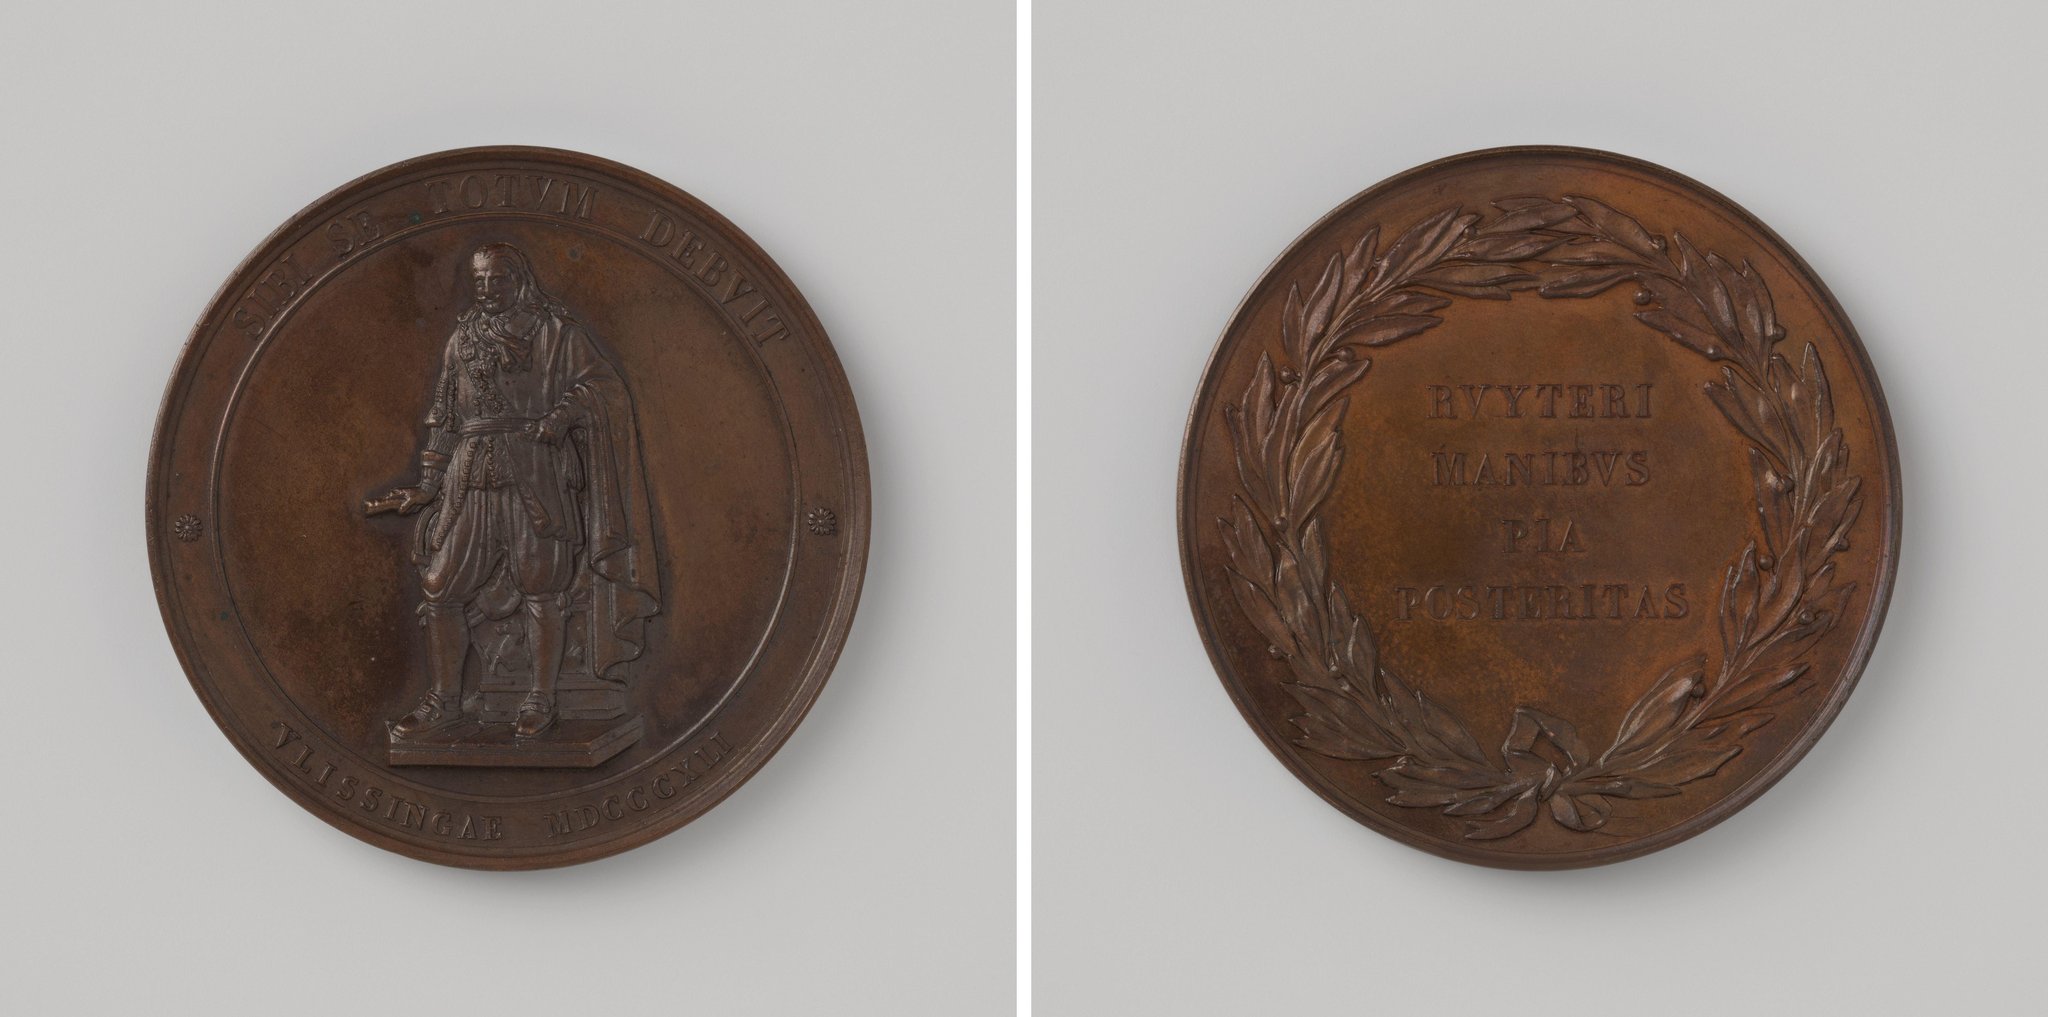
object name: history medal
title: Onthulling van het standbeeld van Michiel de Ruyter te Vlissingen 1841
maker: david van der kellen (1804-1879)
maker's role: die cutter, draughtsman, print maker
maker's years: 1804-1879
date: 1840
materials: bronze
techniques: striking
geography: utrecht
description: Bronzen penning, op de voorzijde het standbeeld van De Ruyter half naar links met omschrift, op de keerzijde vier regels tekst tussen samengestrikte lauwertakken.